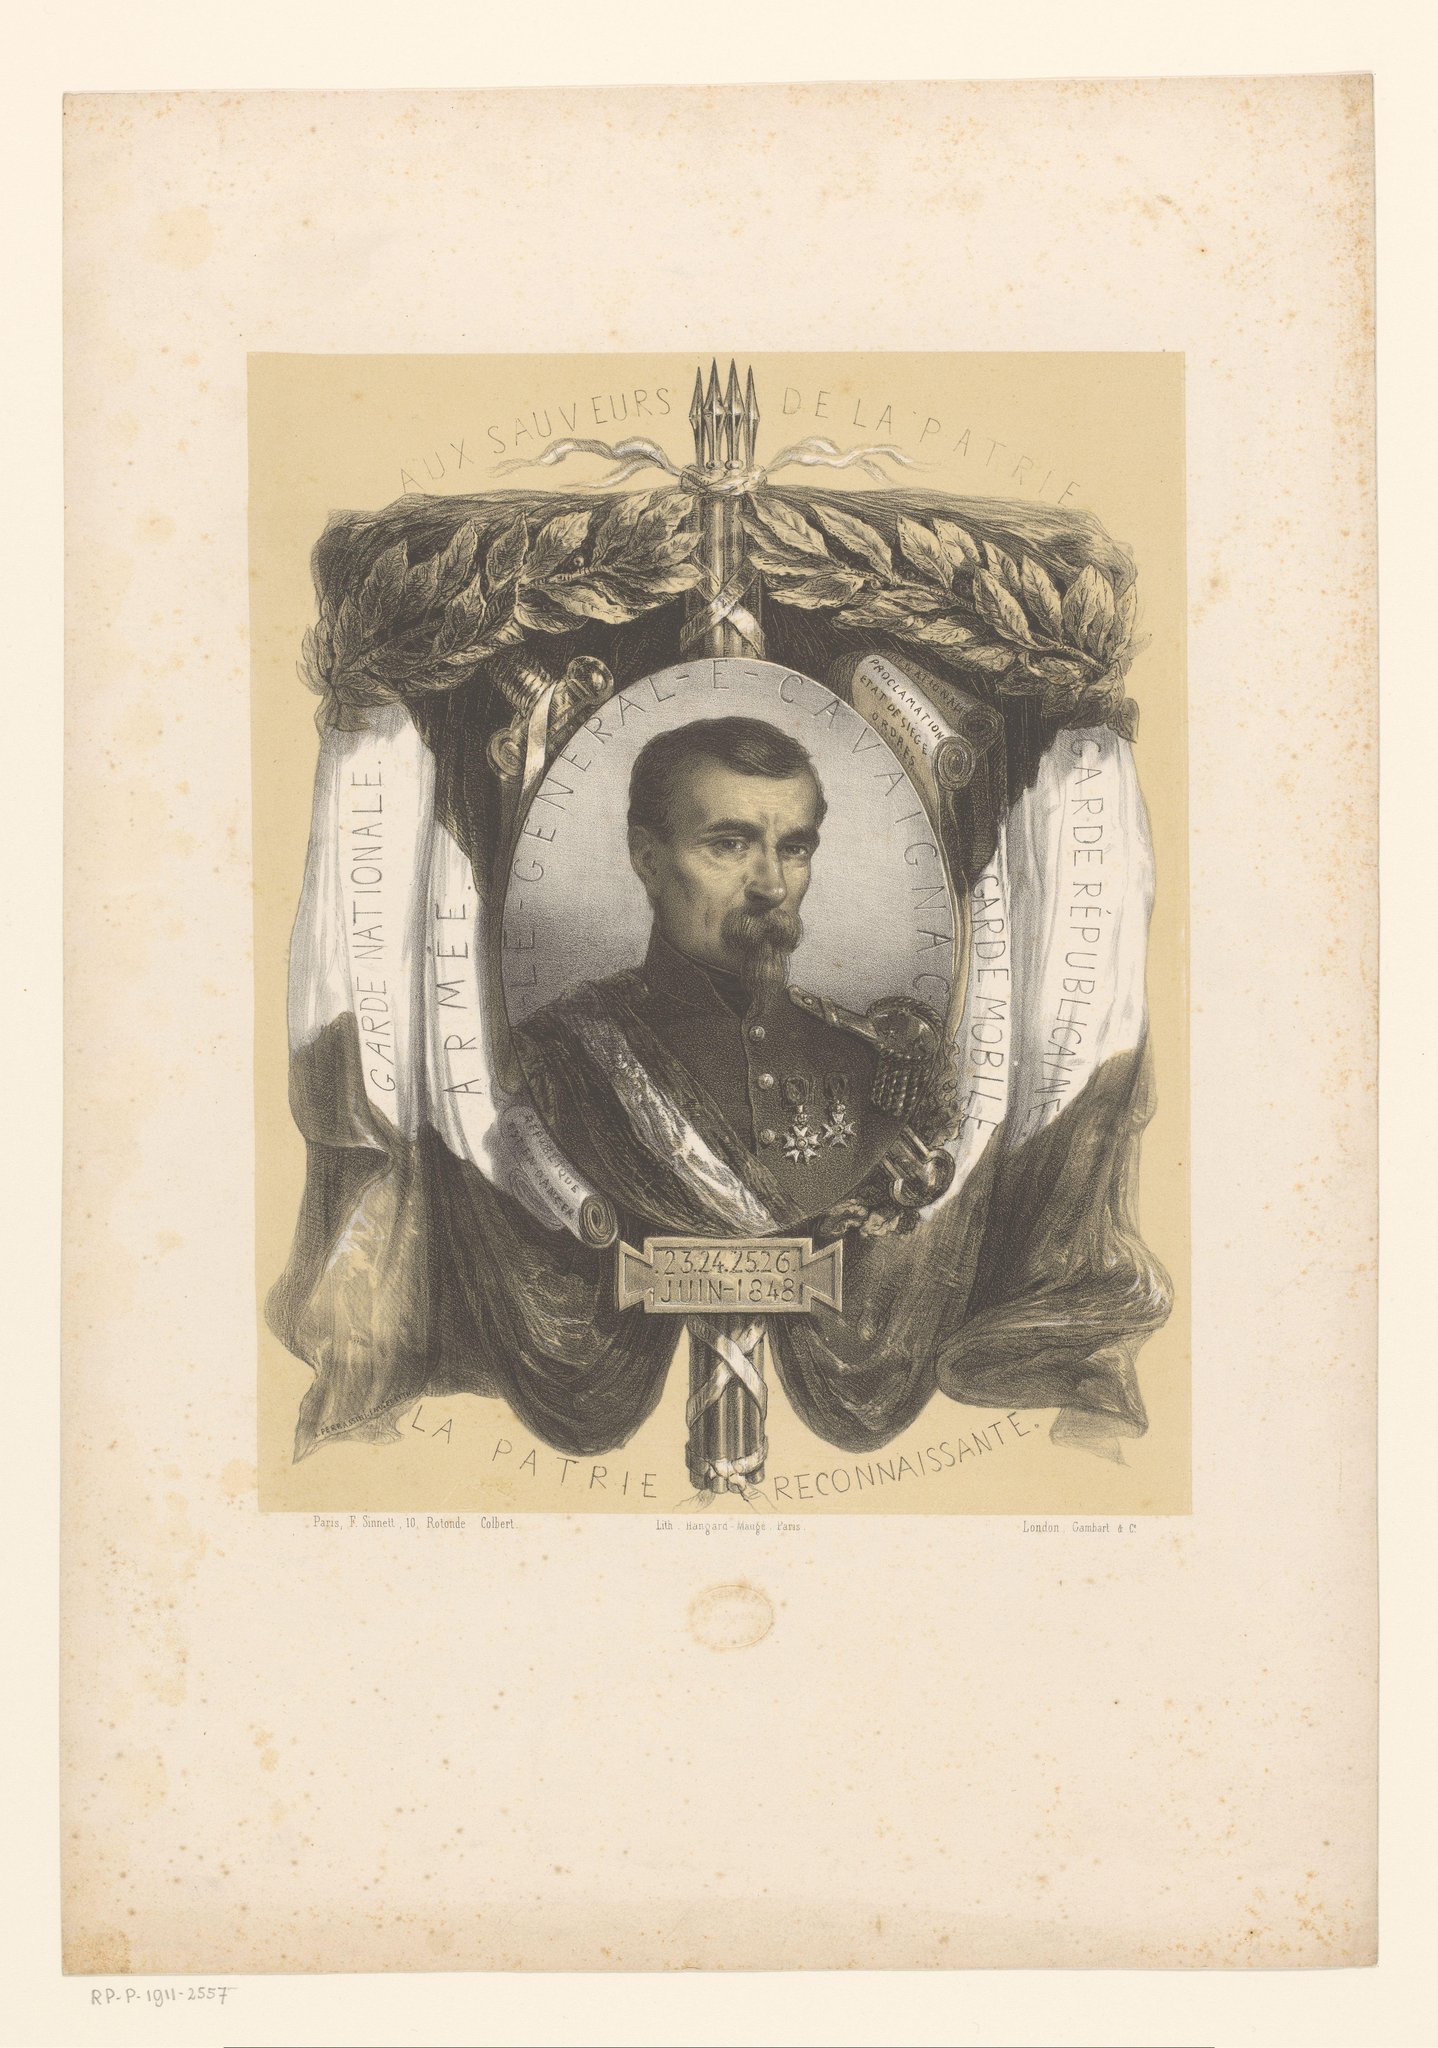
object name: print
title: Le general E Cavaignac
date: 1848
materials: paper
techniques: tone lithography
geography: london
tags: trophy, i.e.: decorative arrangement of symbolic or typical objects ~ ornament, commander-in-chief, general, marshal, historical persons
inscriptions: check stamp: ‘F. Sinnett éditeur à Paris’, collector's mark: Lugt 2228